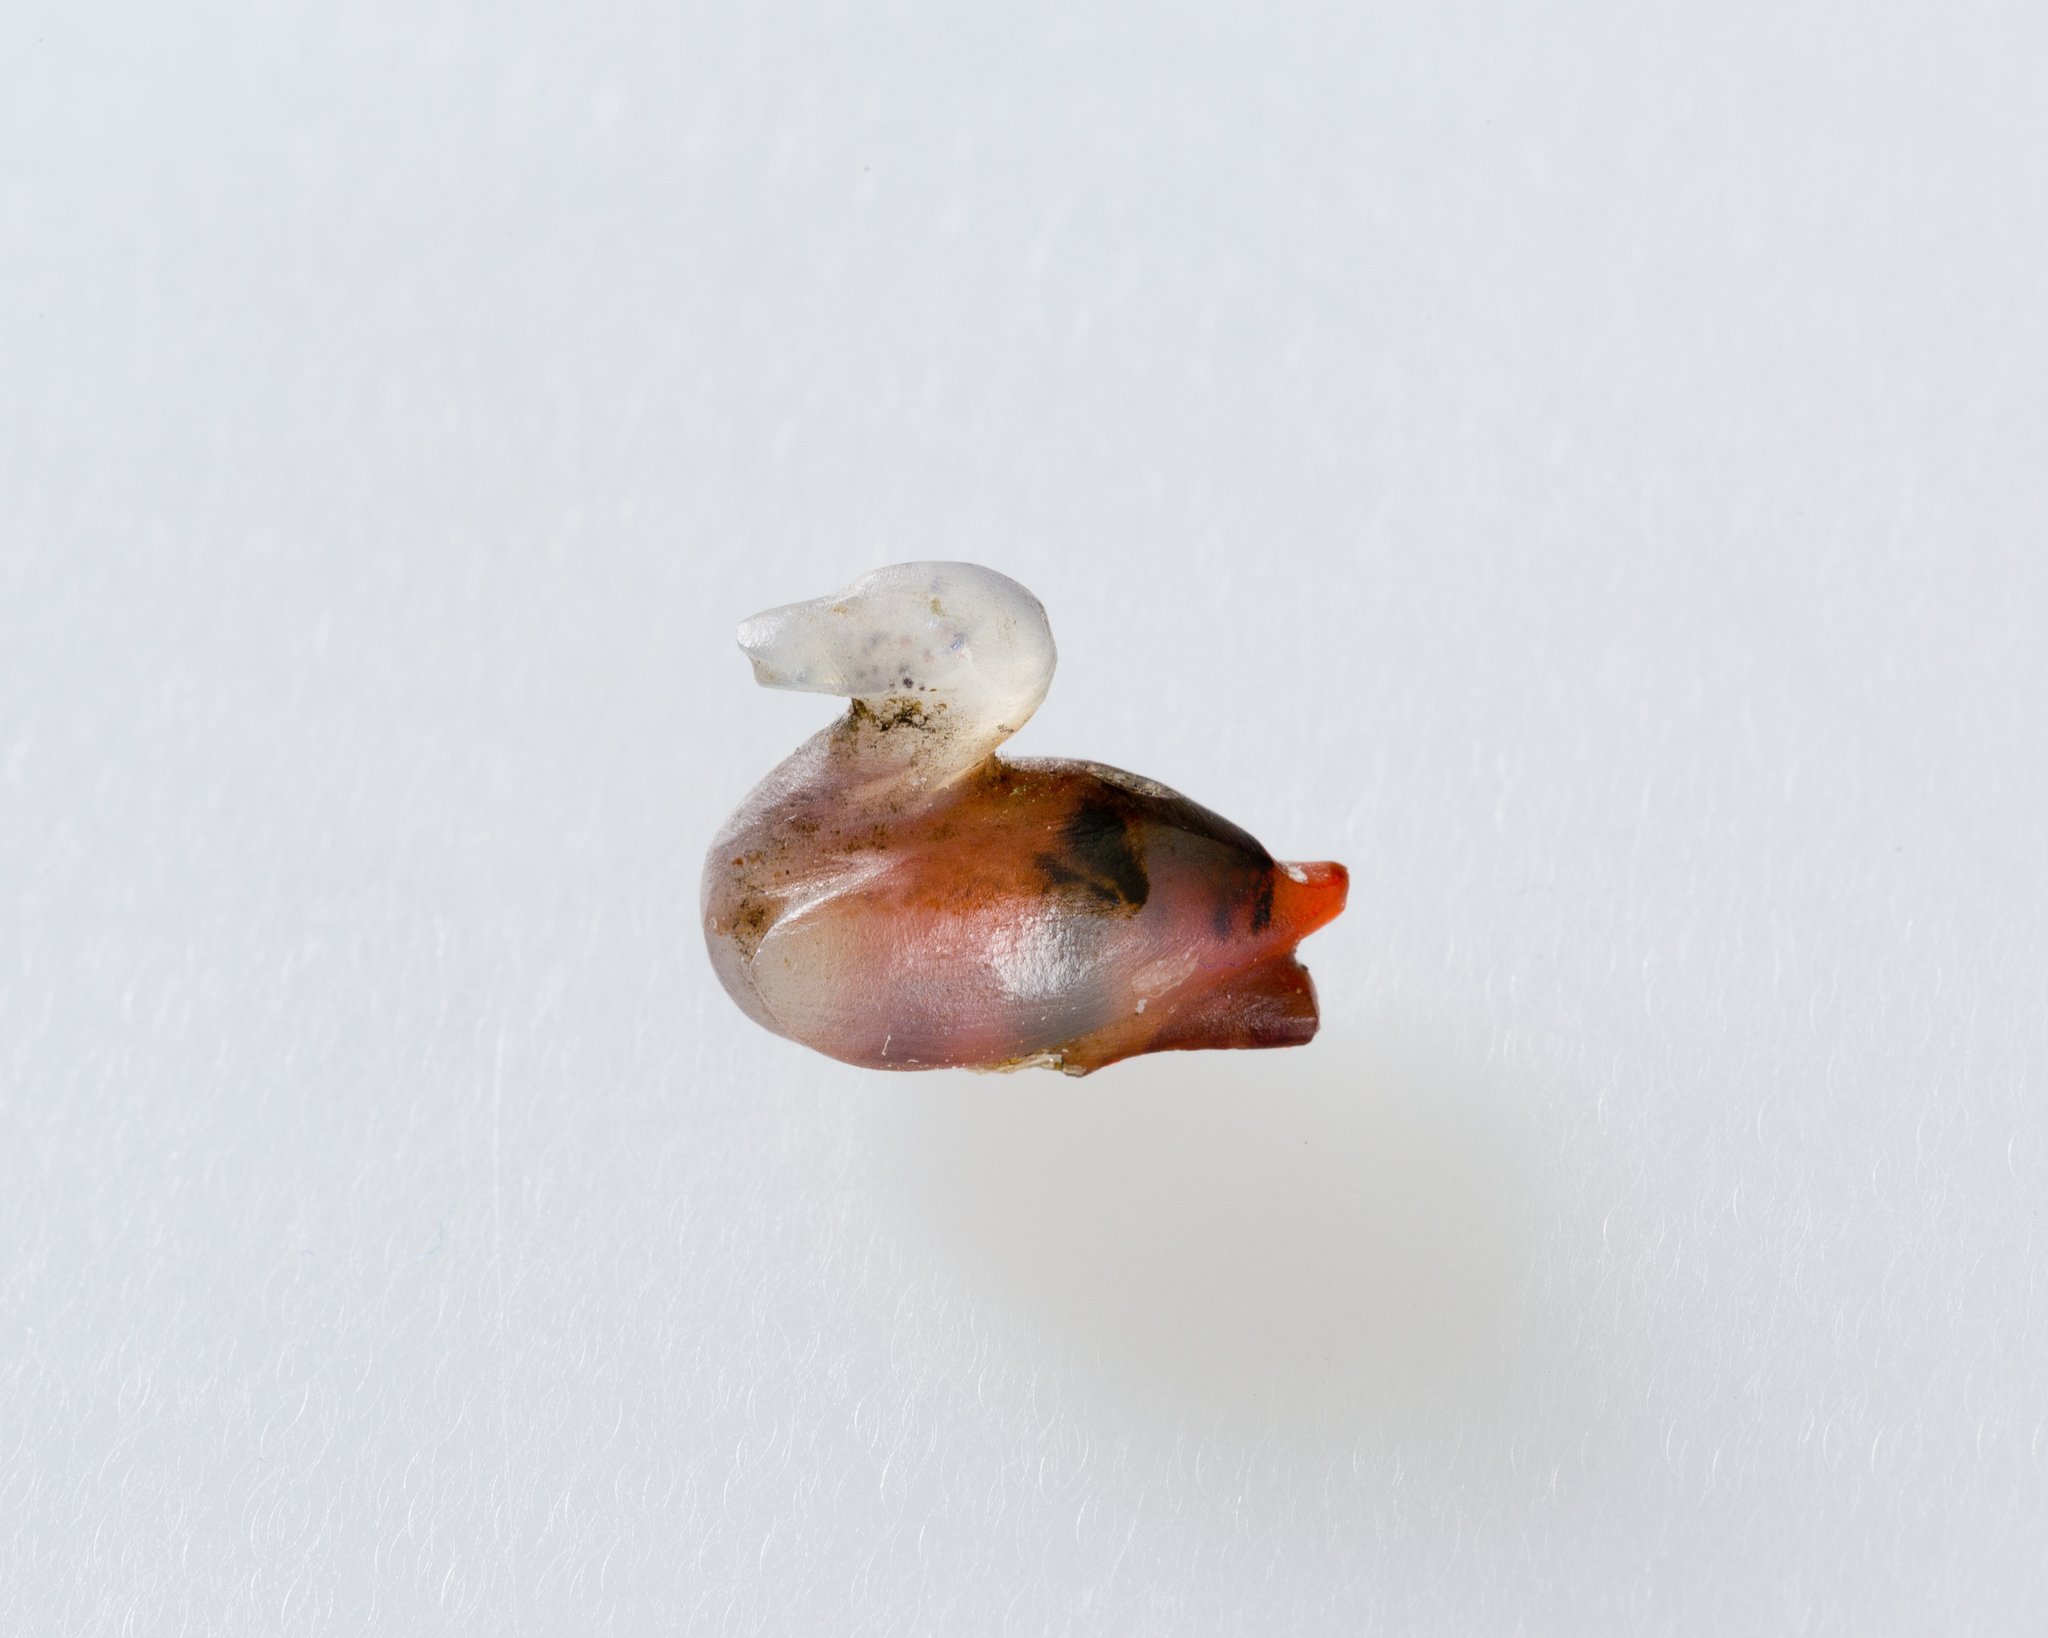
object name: amulet, duck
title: Duck amulet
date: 200 BCE-200 CE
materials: stone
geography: egypt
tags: ducks